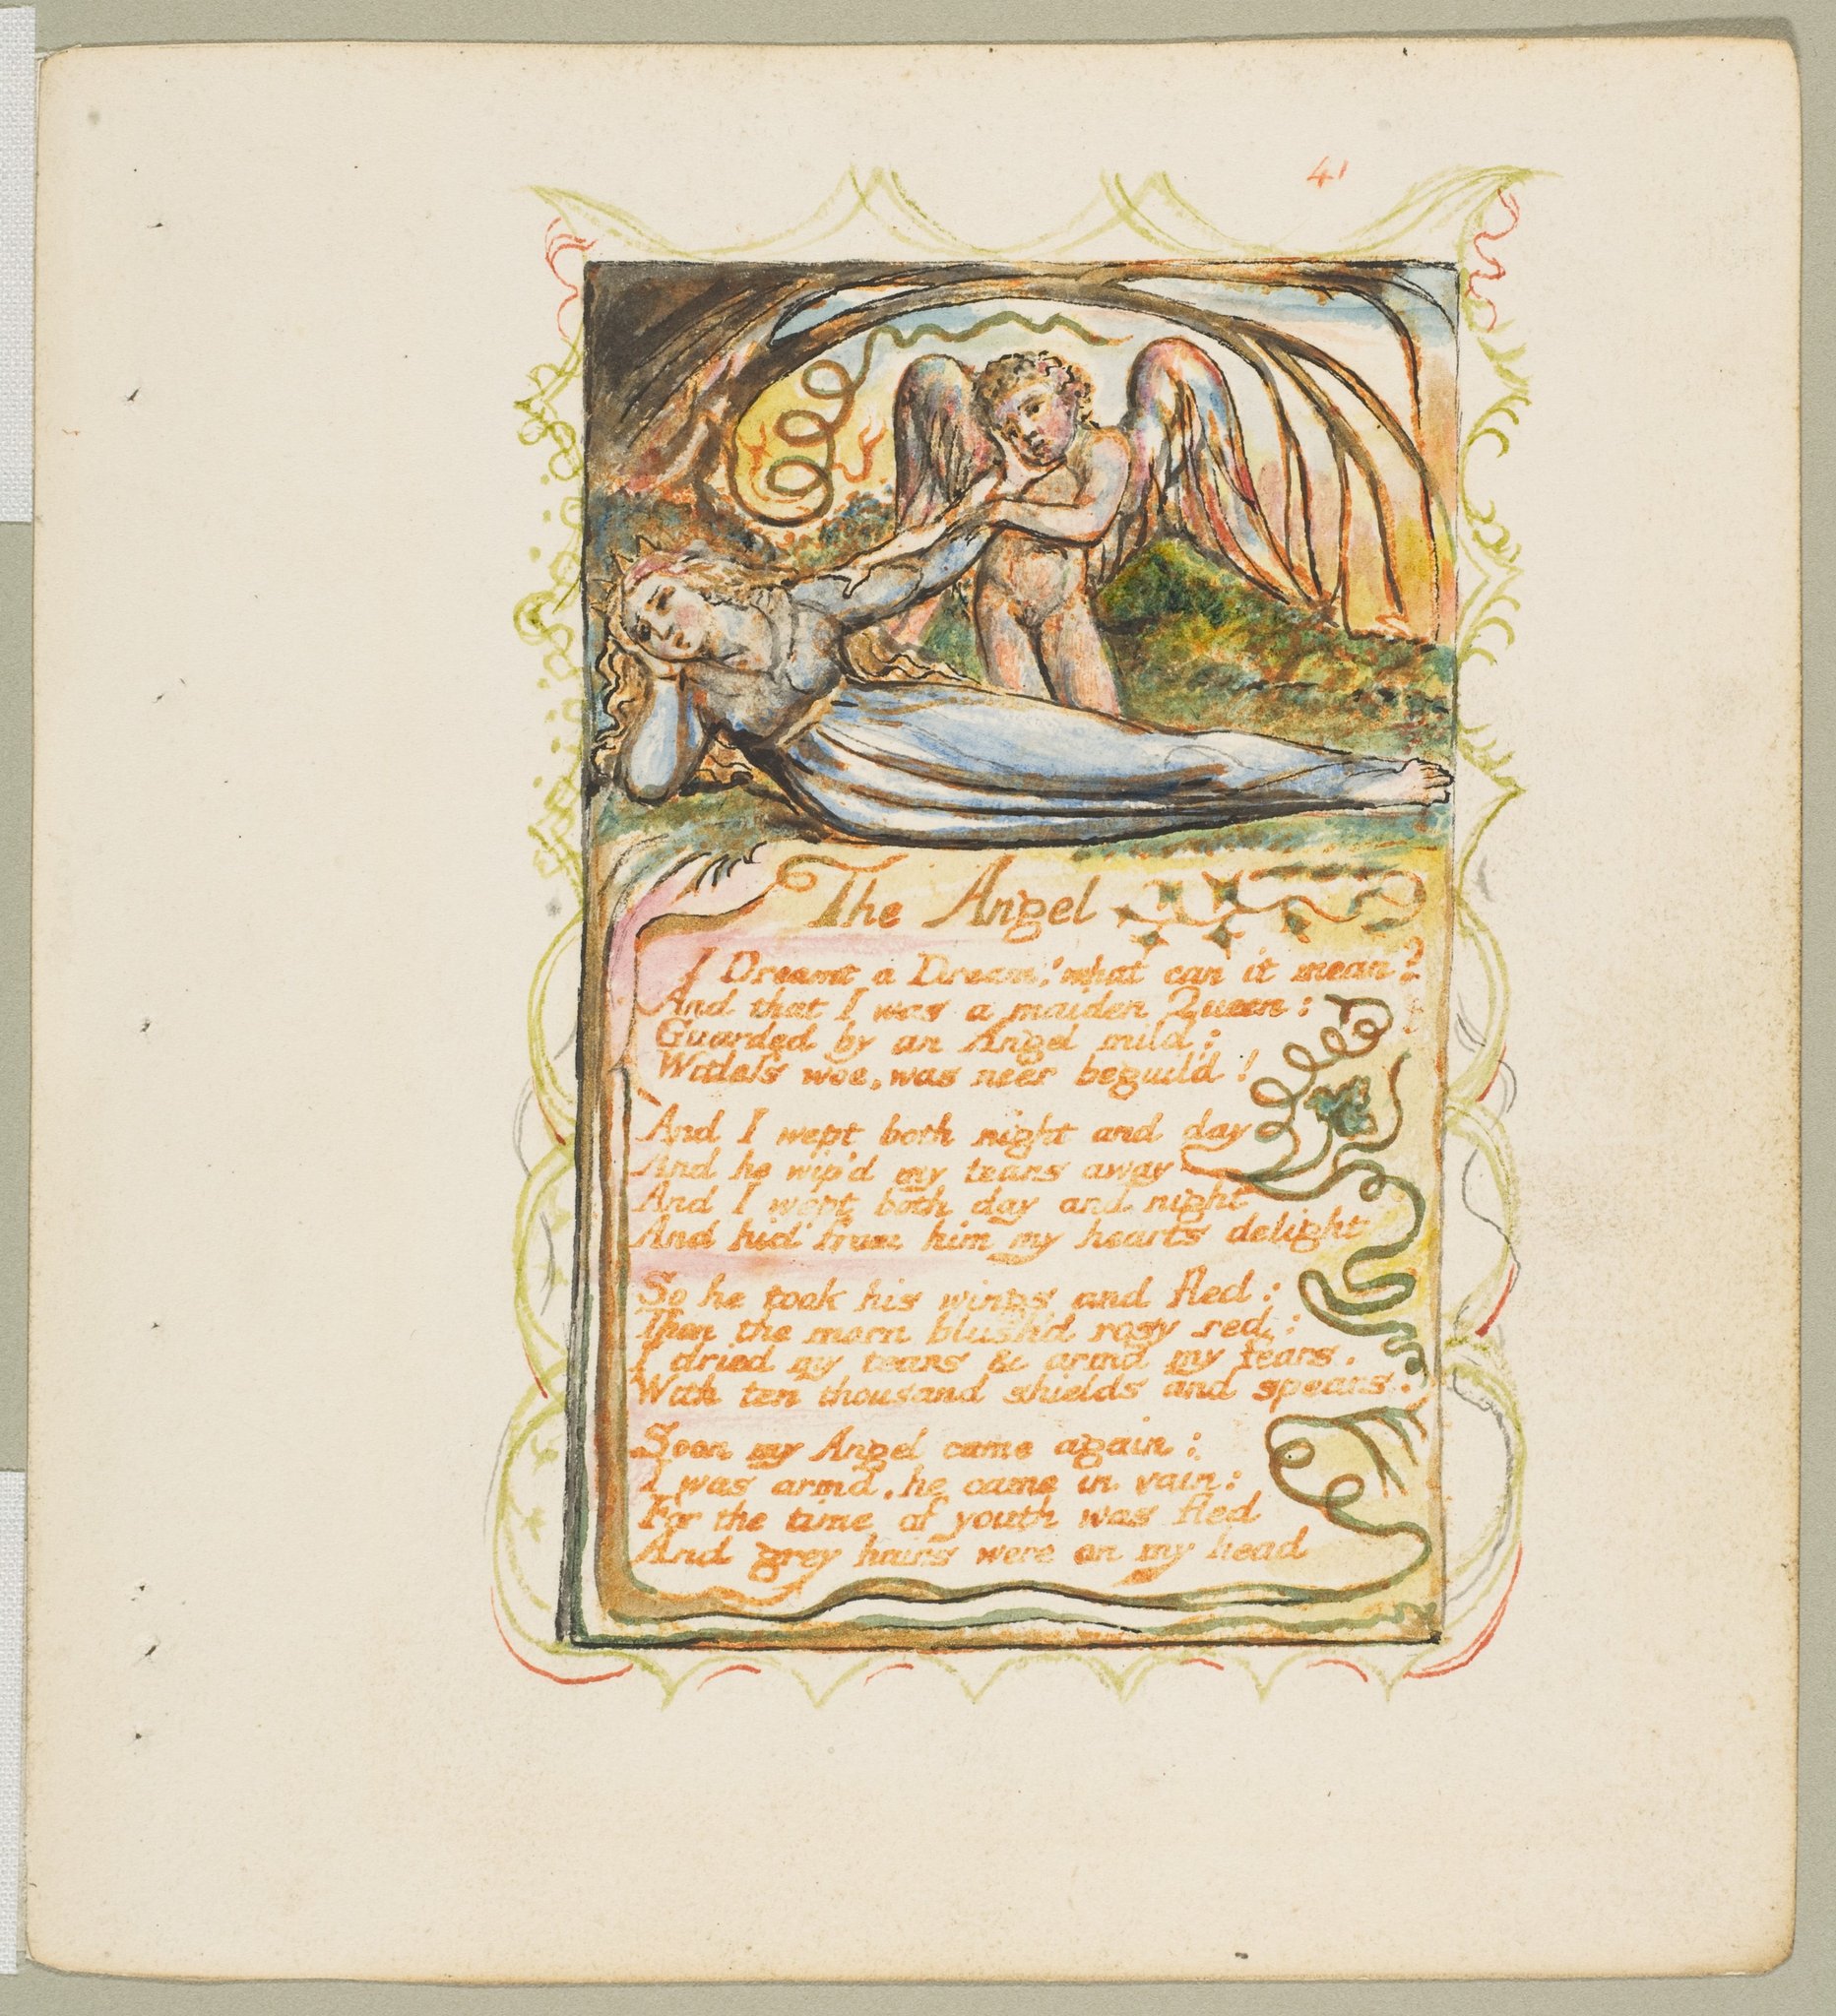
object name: print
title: Songs of Experience: The Angel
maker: william blake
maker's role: artist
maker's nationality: british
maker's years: 1757-1827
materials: gold, ink, shell, watercolor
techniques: etching, hand coloring, printing, relief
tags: poetry,women,angels